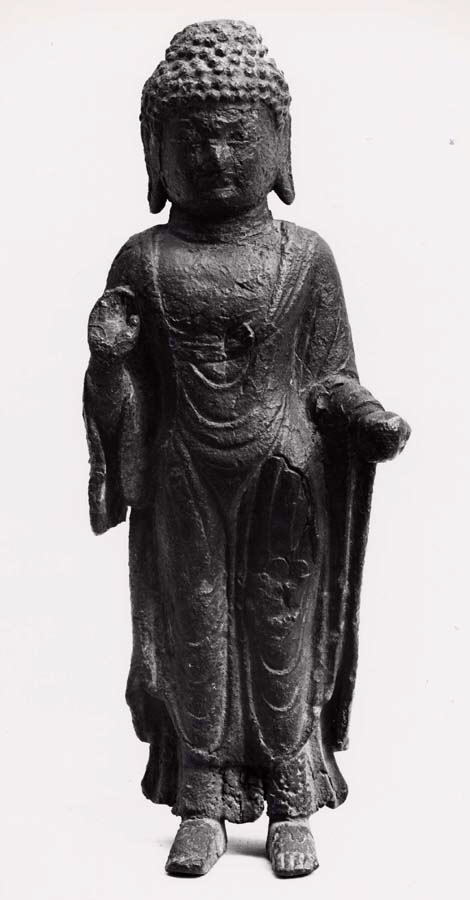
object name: figure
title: Buddha of Medicine (Bhasyajaguru)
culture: korean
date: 1001-1200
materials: bronze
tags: buddhism,buddha